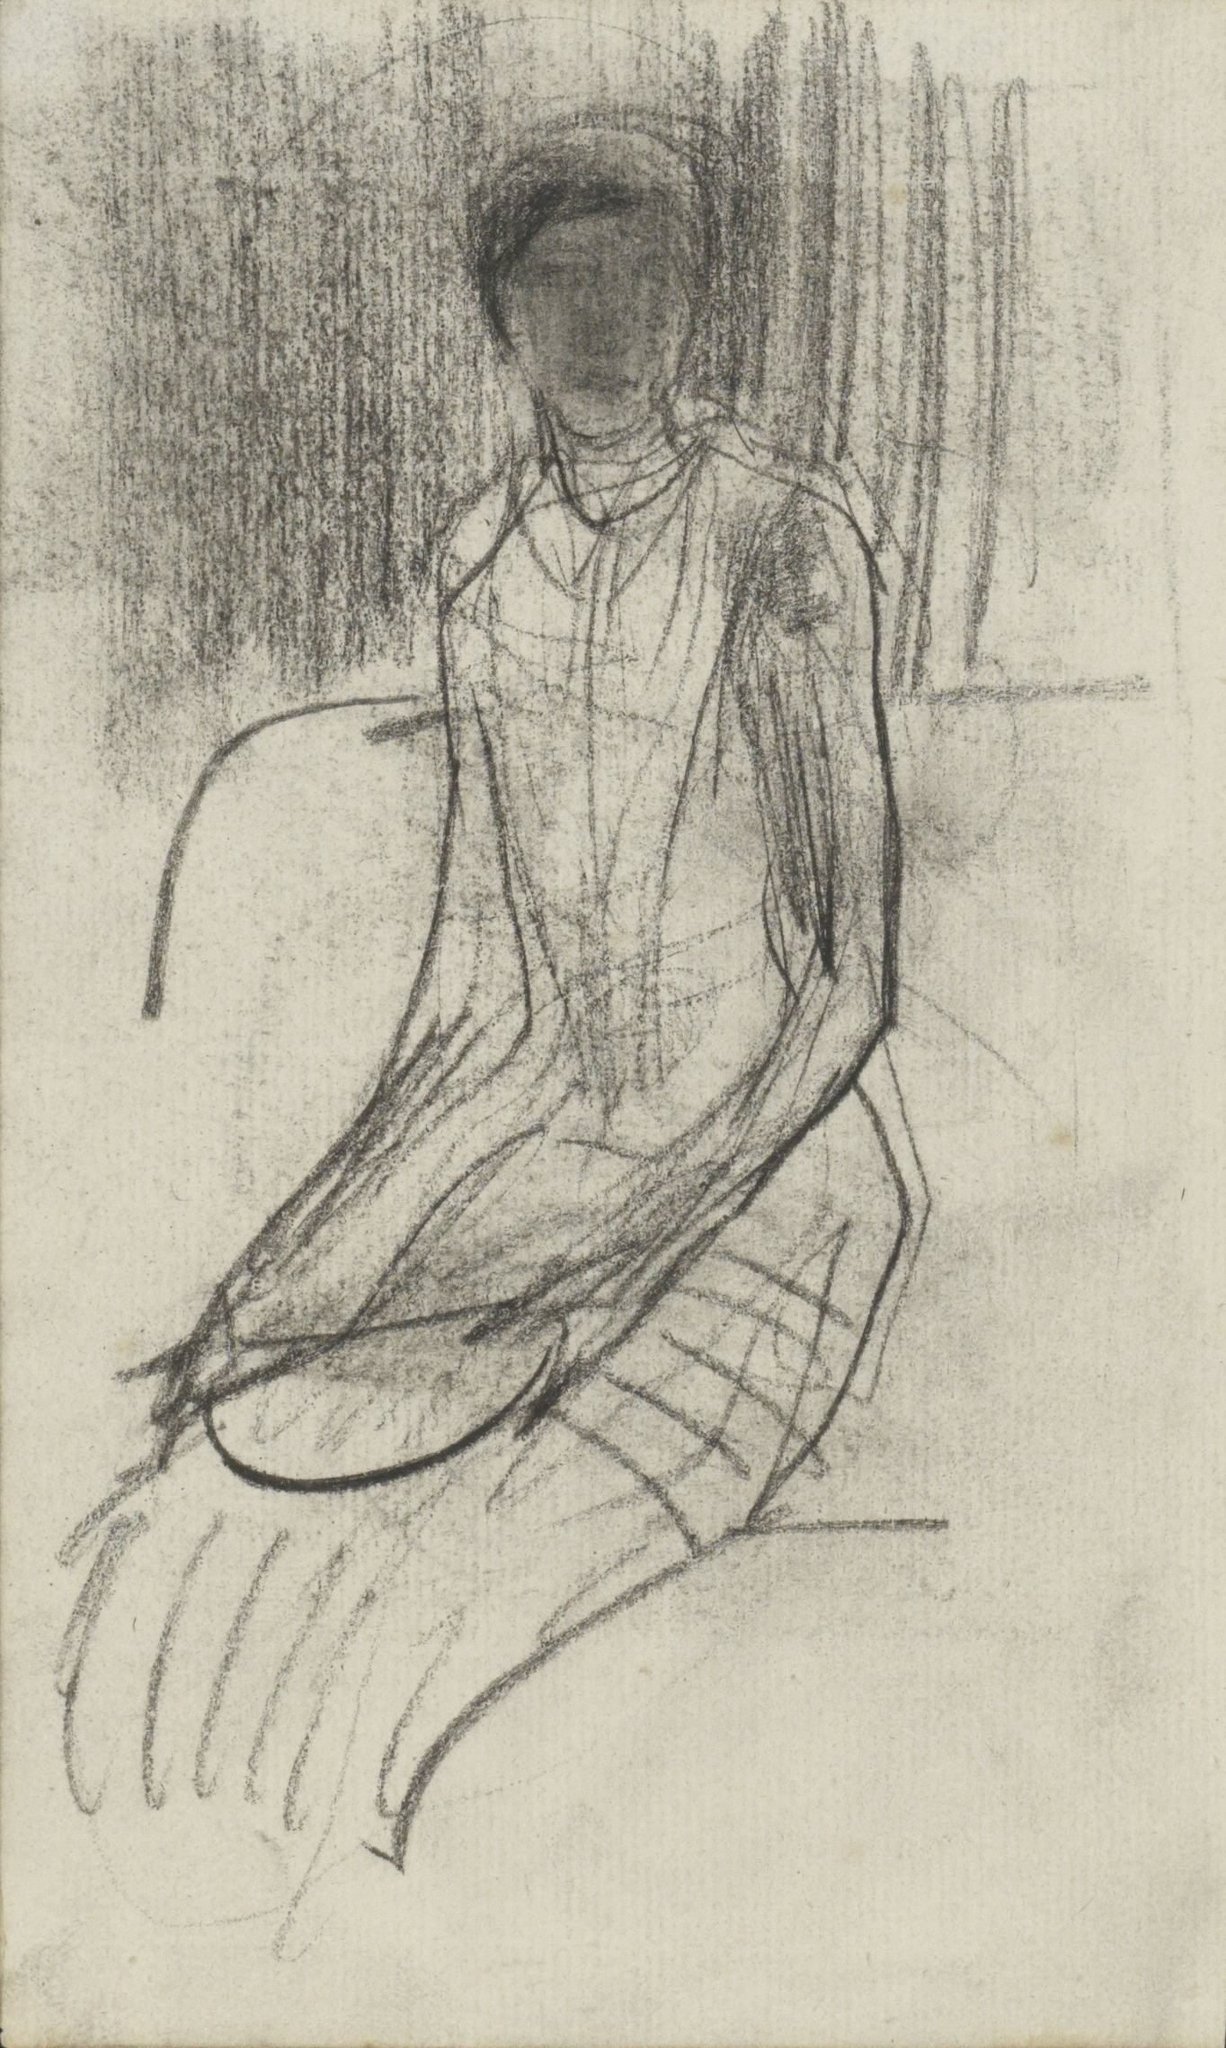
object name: drawing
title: Vrouw op een bank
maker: george hendrik breitner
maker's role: draughtsman, painter, print maker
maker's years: 1857-1923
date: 1873-1923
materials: chalk, paper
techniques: stumping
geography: the hague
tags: couch, sofa, settee, sitting on an elevation - aa - female human figure